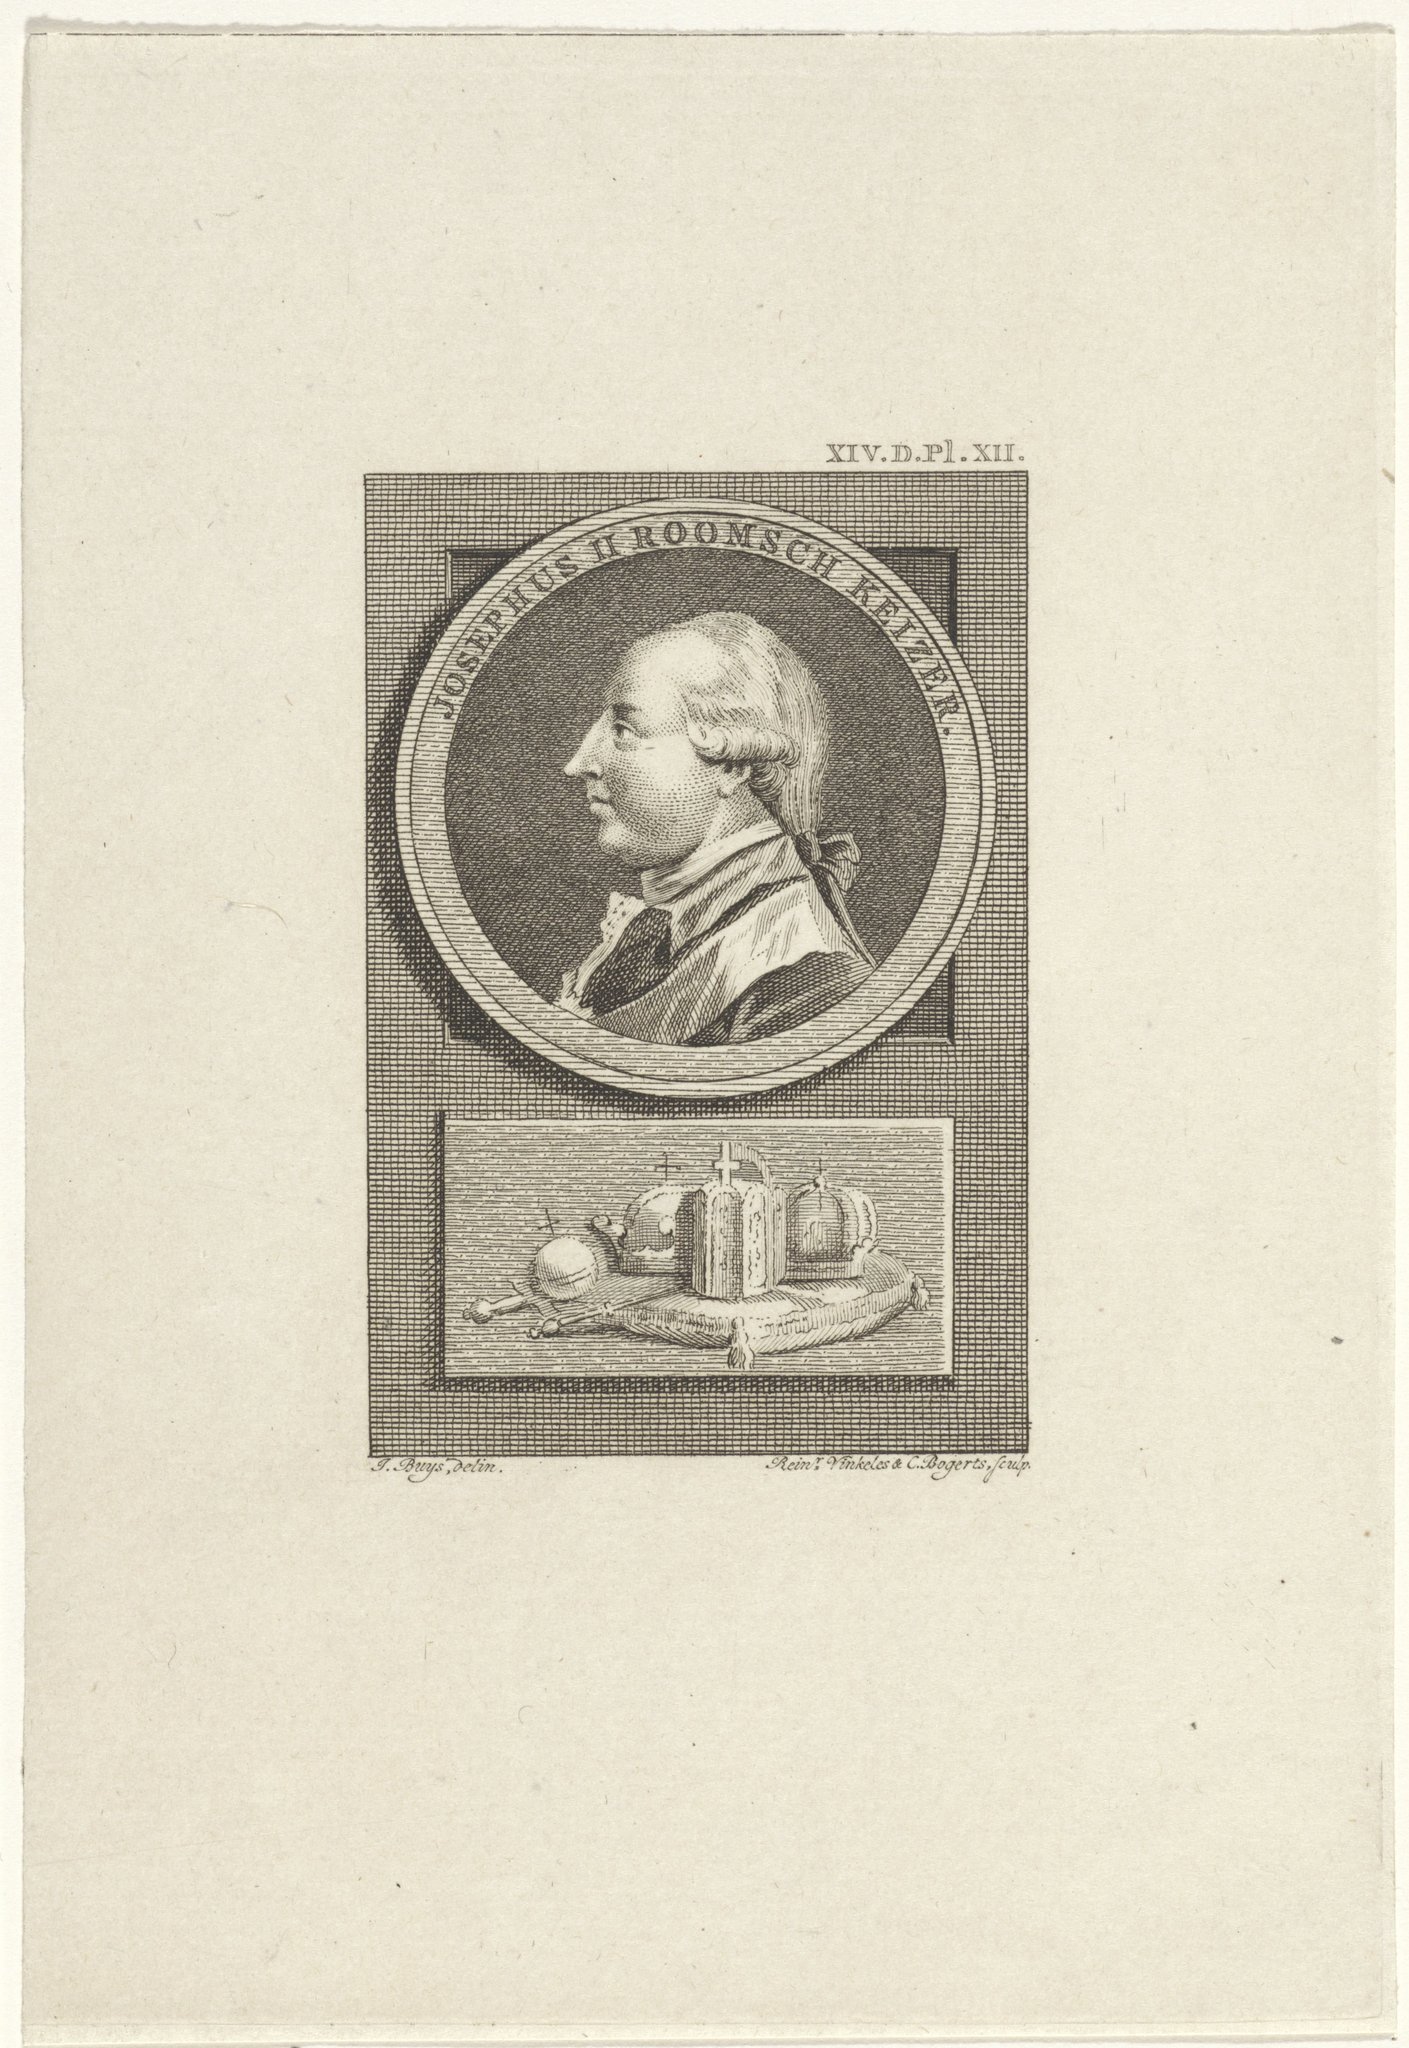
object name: book illustration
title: Portret van Jozef II, Duits keizer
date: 1783-1795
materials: paper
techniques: engraving, etching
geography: amsterdam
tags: vienna, jozef ii (duits keizer), crown (symbol of sovereignty), orb (symbol of sovereignty; sphere with cross on top), sceptre, staff (symbol of sovereignty)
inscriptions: collector's mark: Lugt 2228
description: Prent gebruikt in: Fokke, Jan. Geschiedenissen der Vereenigde Nederlanden voor de vaderlandsche jeugd Ie-XXVste deel. Amsterdam: Johannes Allart, 1783-1795. Deel XIV.